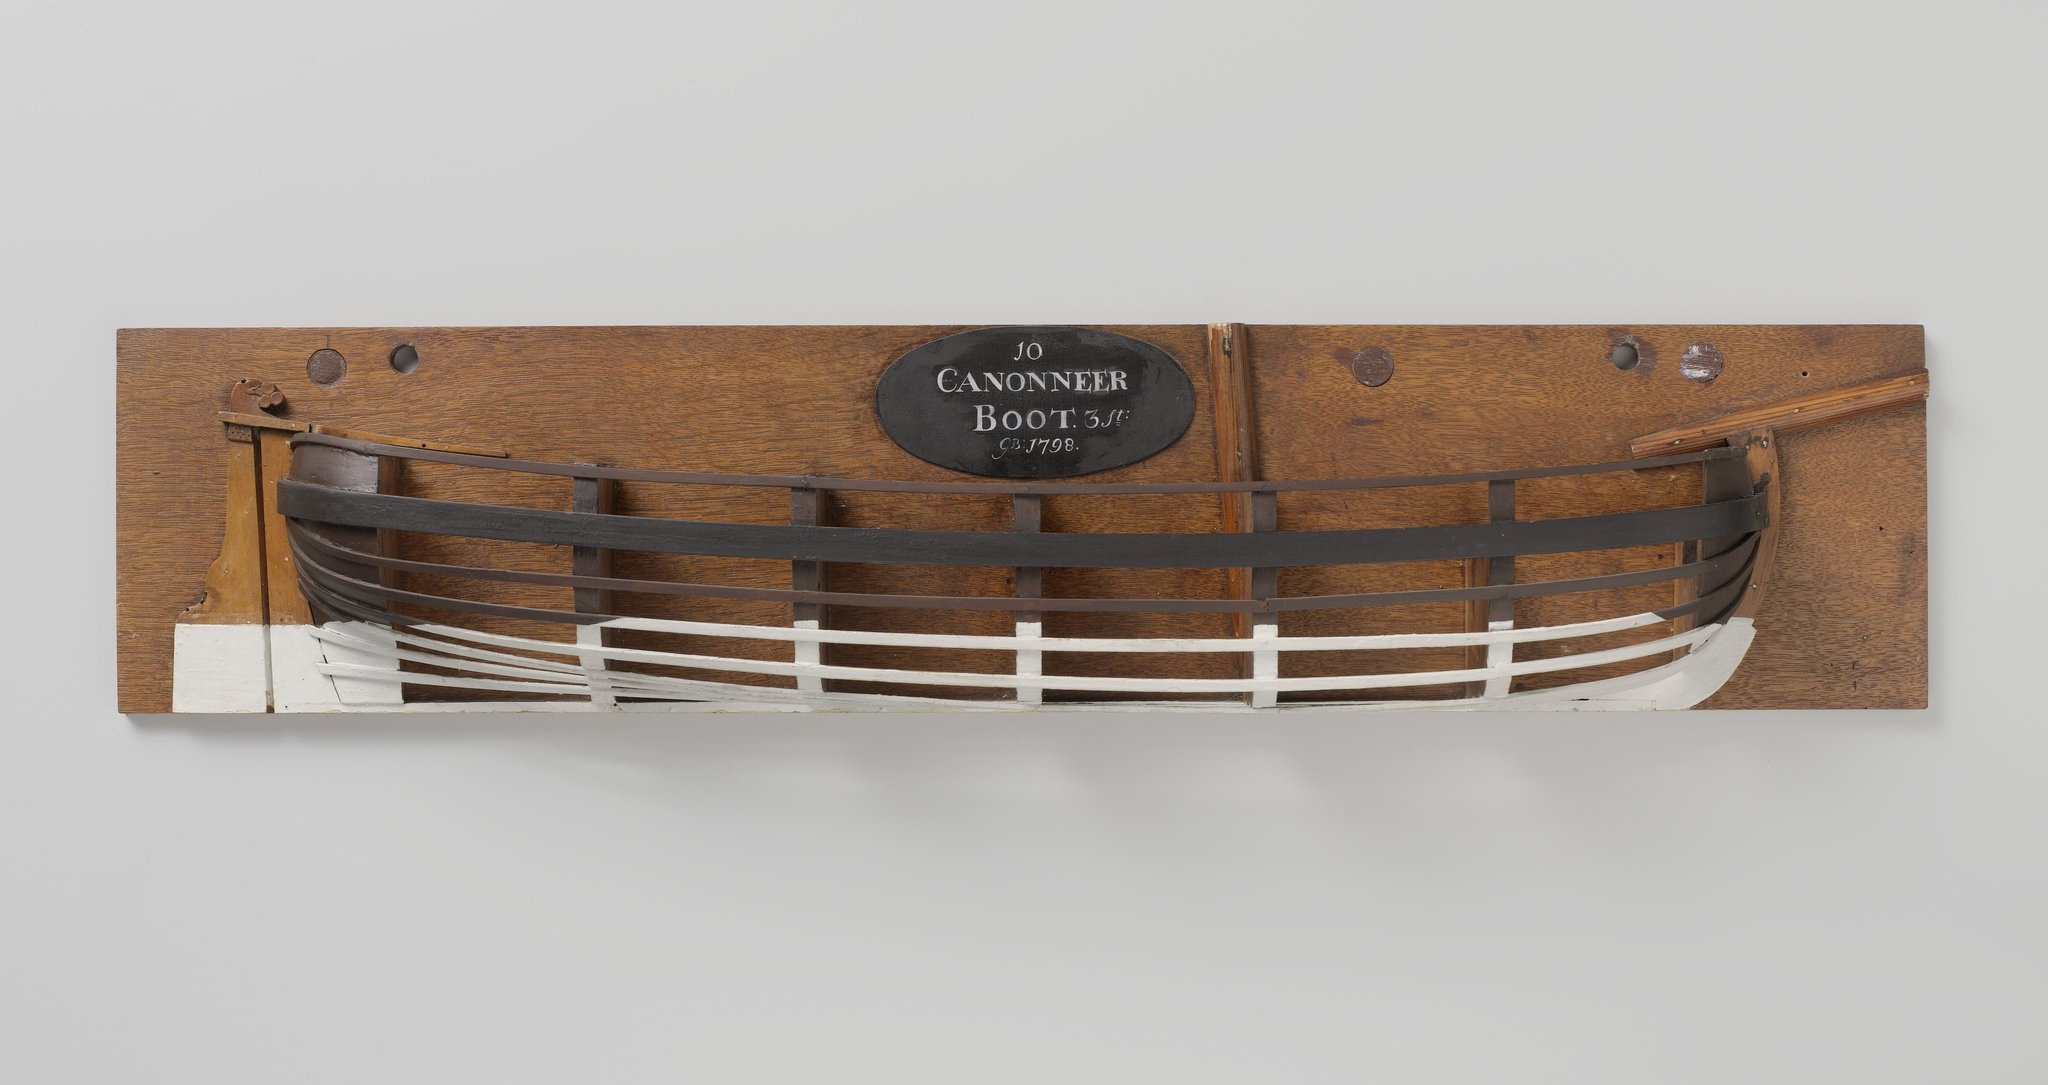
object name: half model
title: Half Model of a 3-Gun Gunboat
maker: Anonymous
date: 1798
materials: wood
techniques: polychromy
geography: netherlands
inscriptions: inscription, top centre, on an oval black label: ‘10 / CANONNEER / BOOT. 3 St: / GB: 1798.’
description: Gepolychromeerd mallenmodel (stuurboord) van een eenmast platbodem. Eén geschutpoort in de boeg. Rond achterschip, breed roer met helmstok over dek; roerkop versierd met bloemmotief. De zeeg loopt naar voren en achter op, één barkhout.